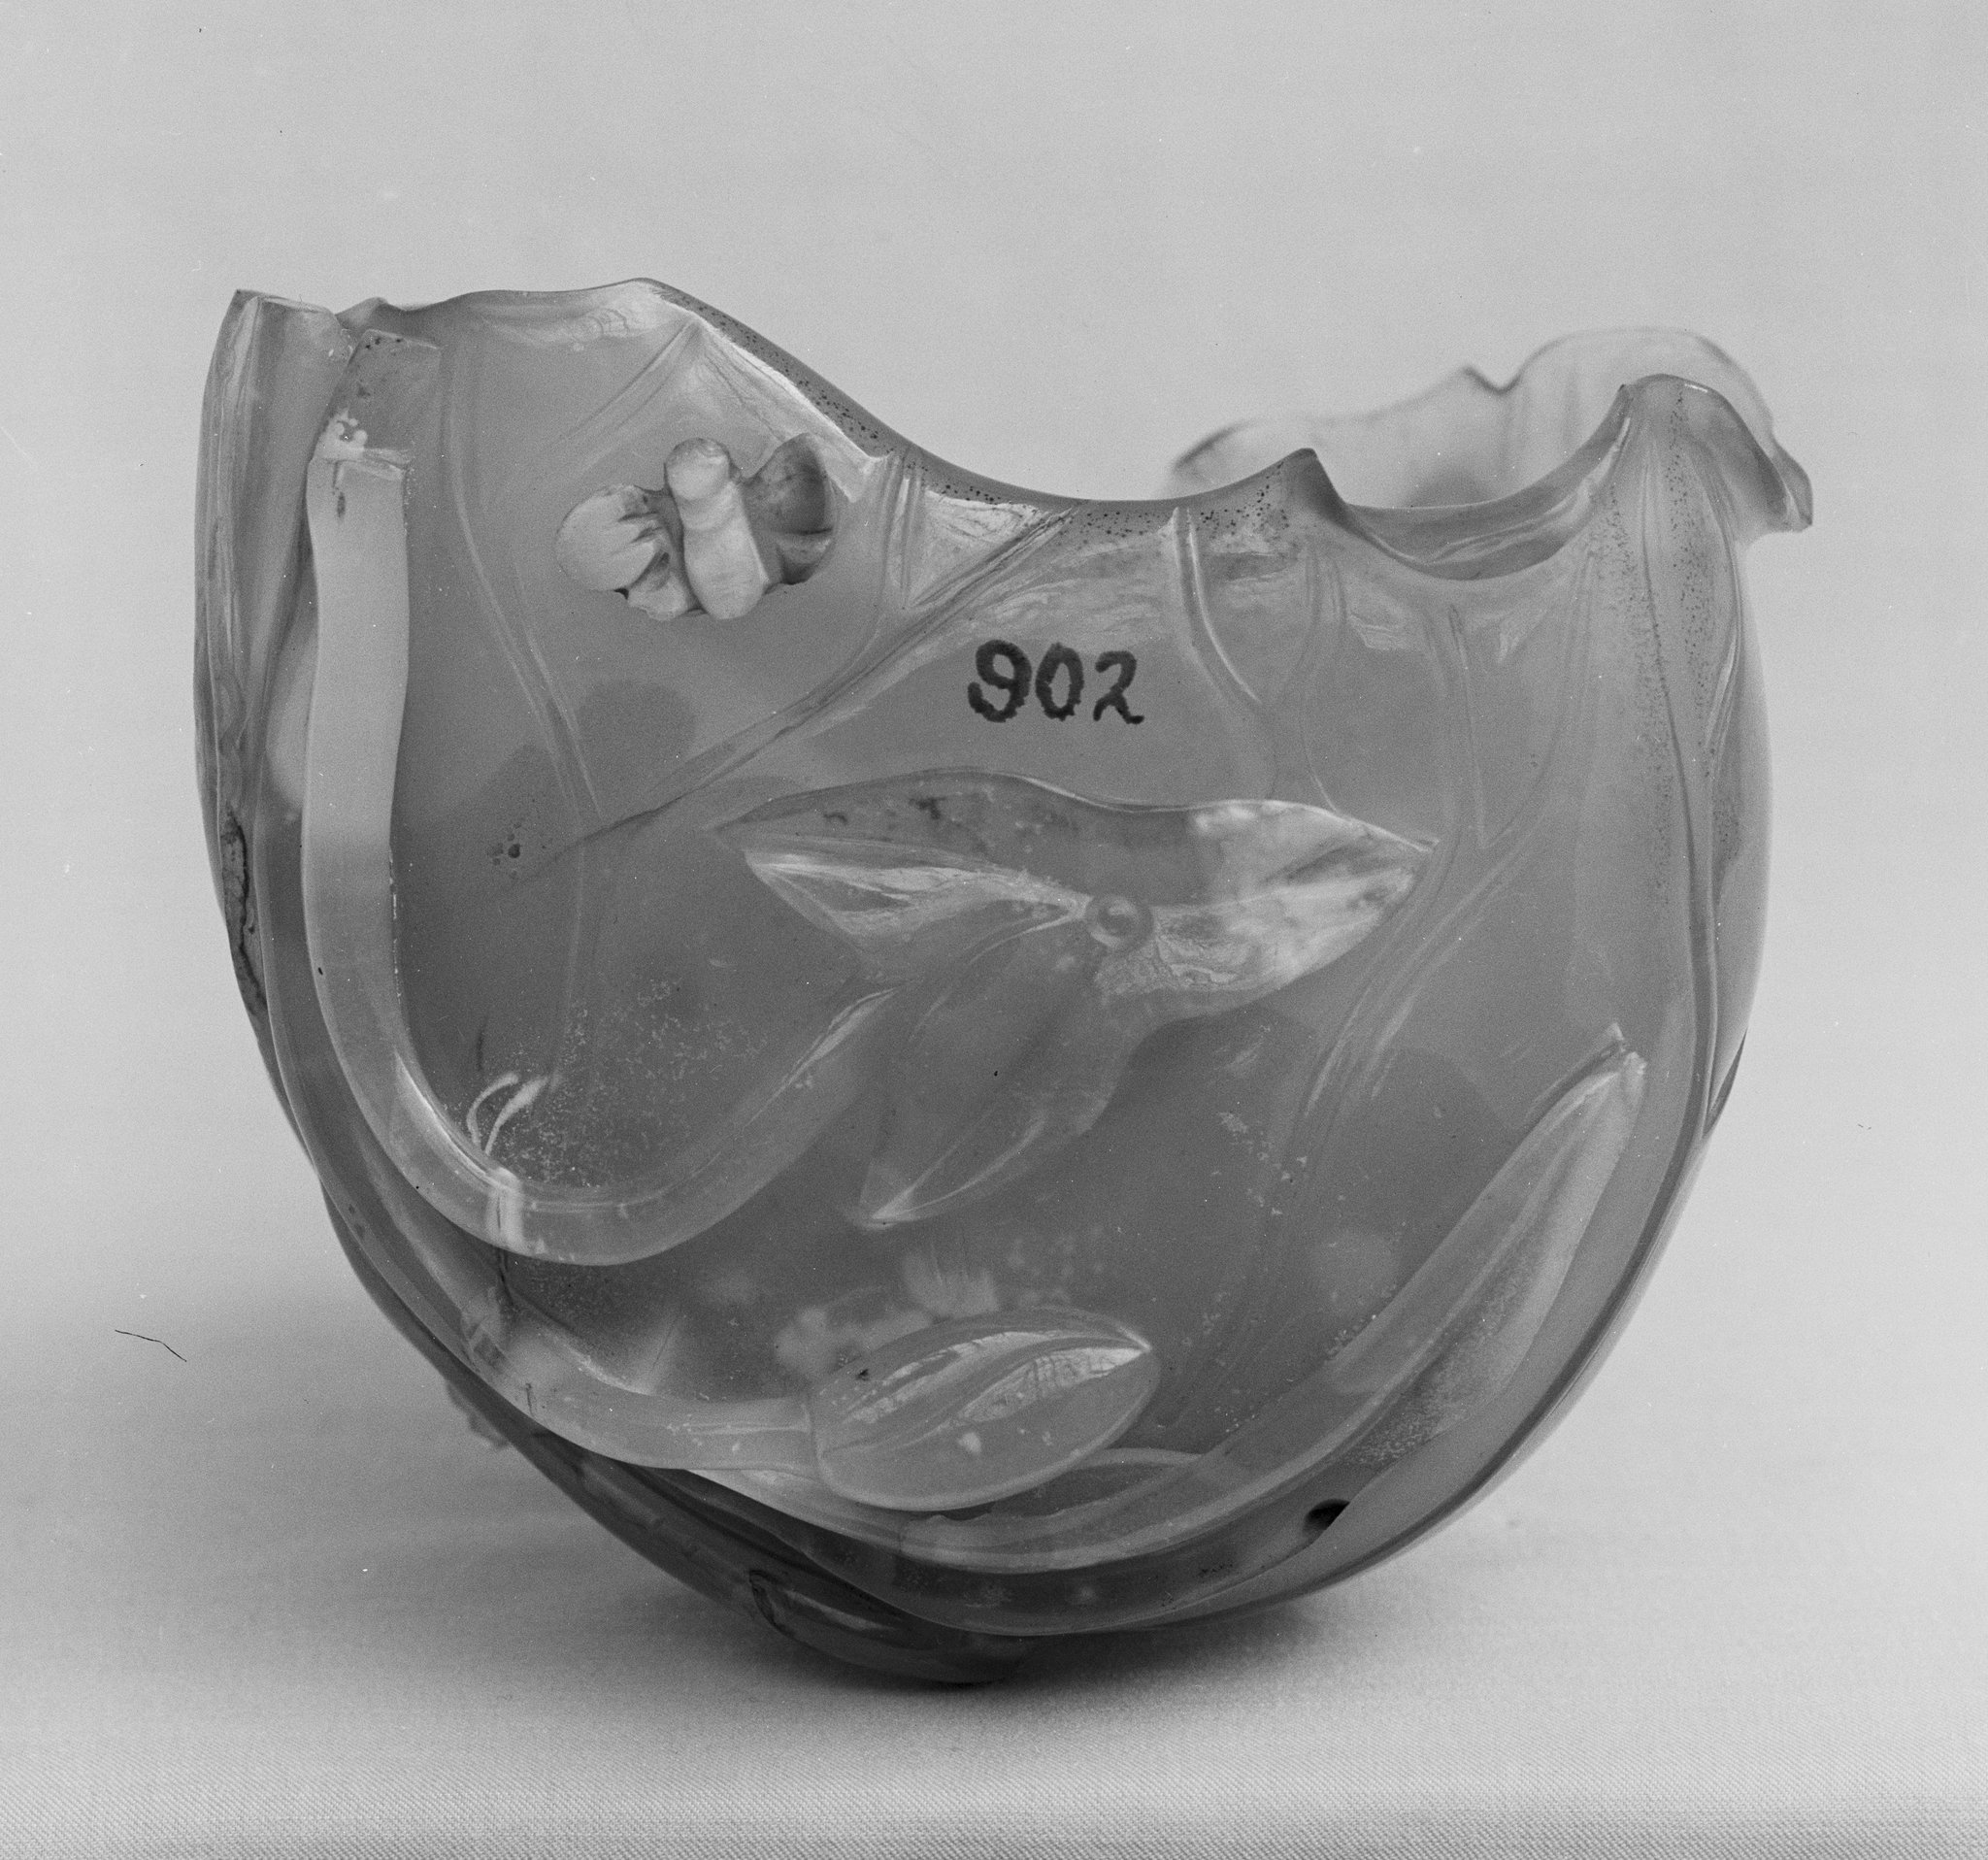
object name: cup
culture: chinese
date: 1701-1800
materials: stone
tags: leaves